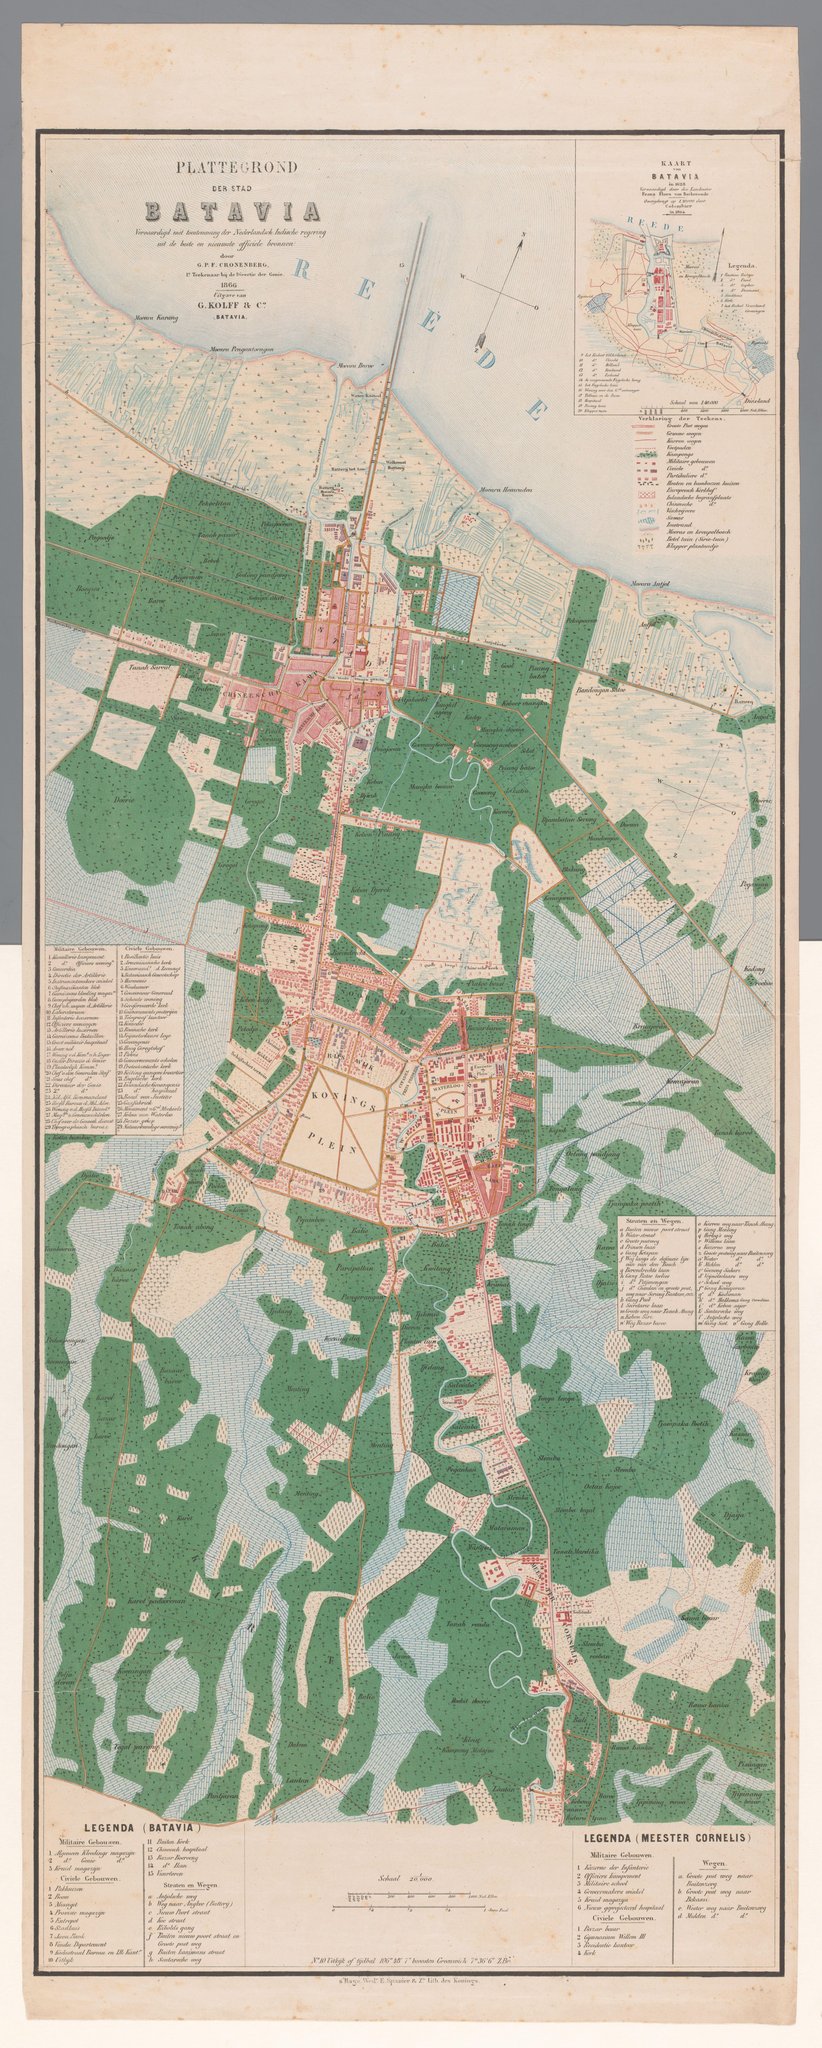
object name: map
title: Plattegrond van de stad Batavia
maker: frans florisz. van berckenrode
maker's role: draughtsman, print maker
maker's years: 1593-1634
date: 1866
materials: paper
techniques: lithograph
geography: batavia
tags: maps of cities, batavia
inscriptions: collector's mark: Lugt 2228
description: Plattegrond van Batavia (Jakarta) in 1866, met omliggend gebied, inclusief Meester Cornelis (Jatinegara). Rechtsboven een inzet van de toestand van Batavia in 1628 door Frans Floris van Berkenroode, teruggebracht tot een schaal van 1:40.000 door Colombier.